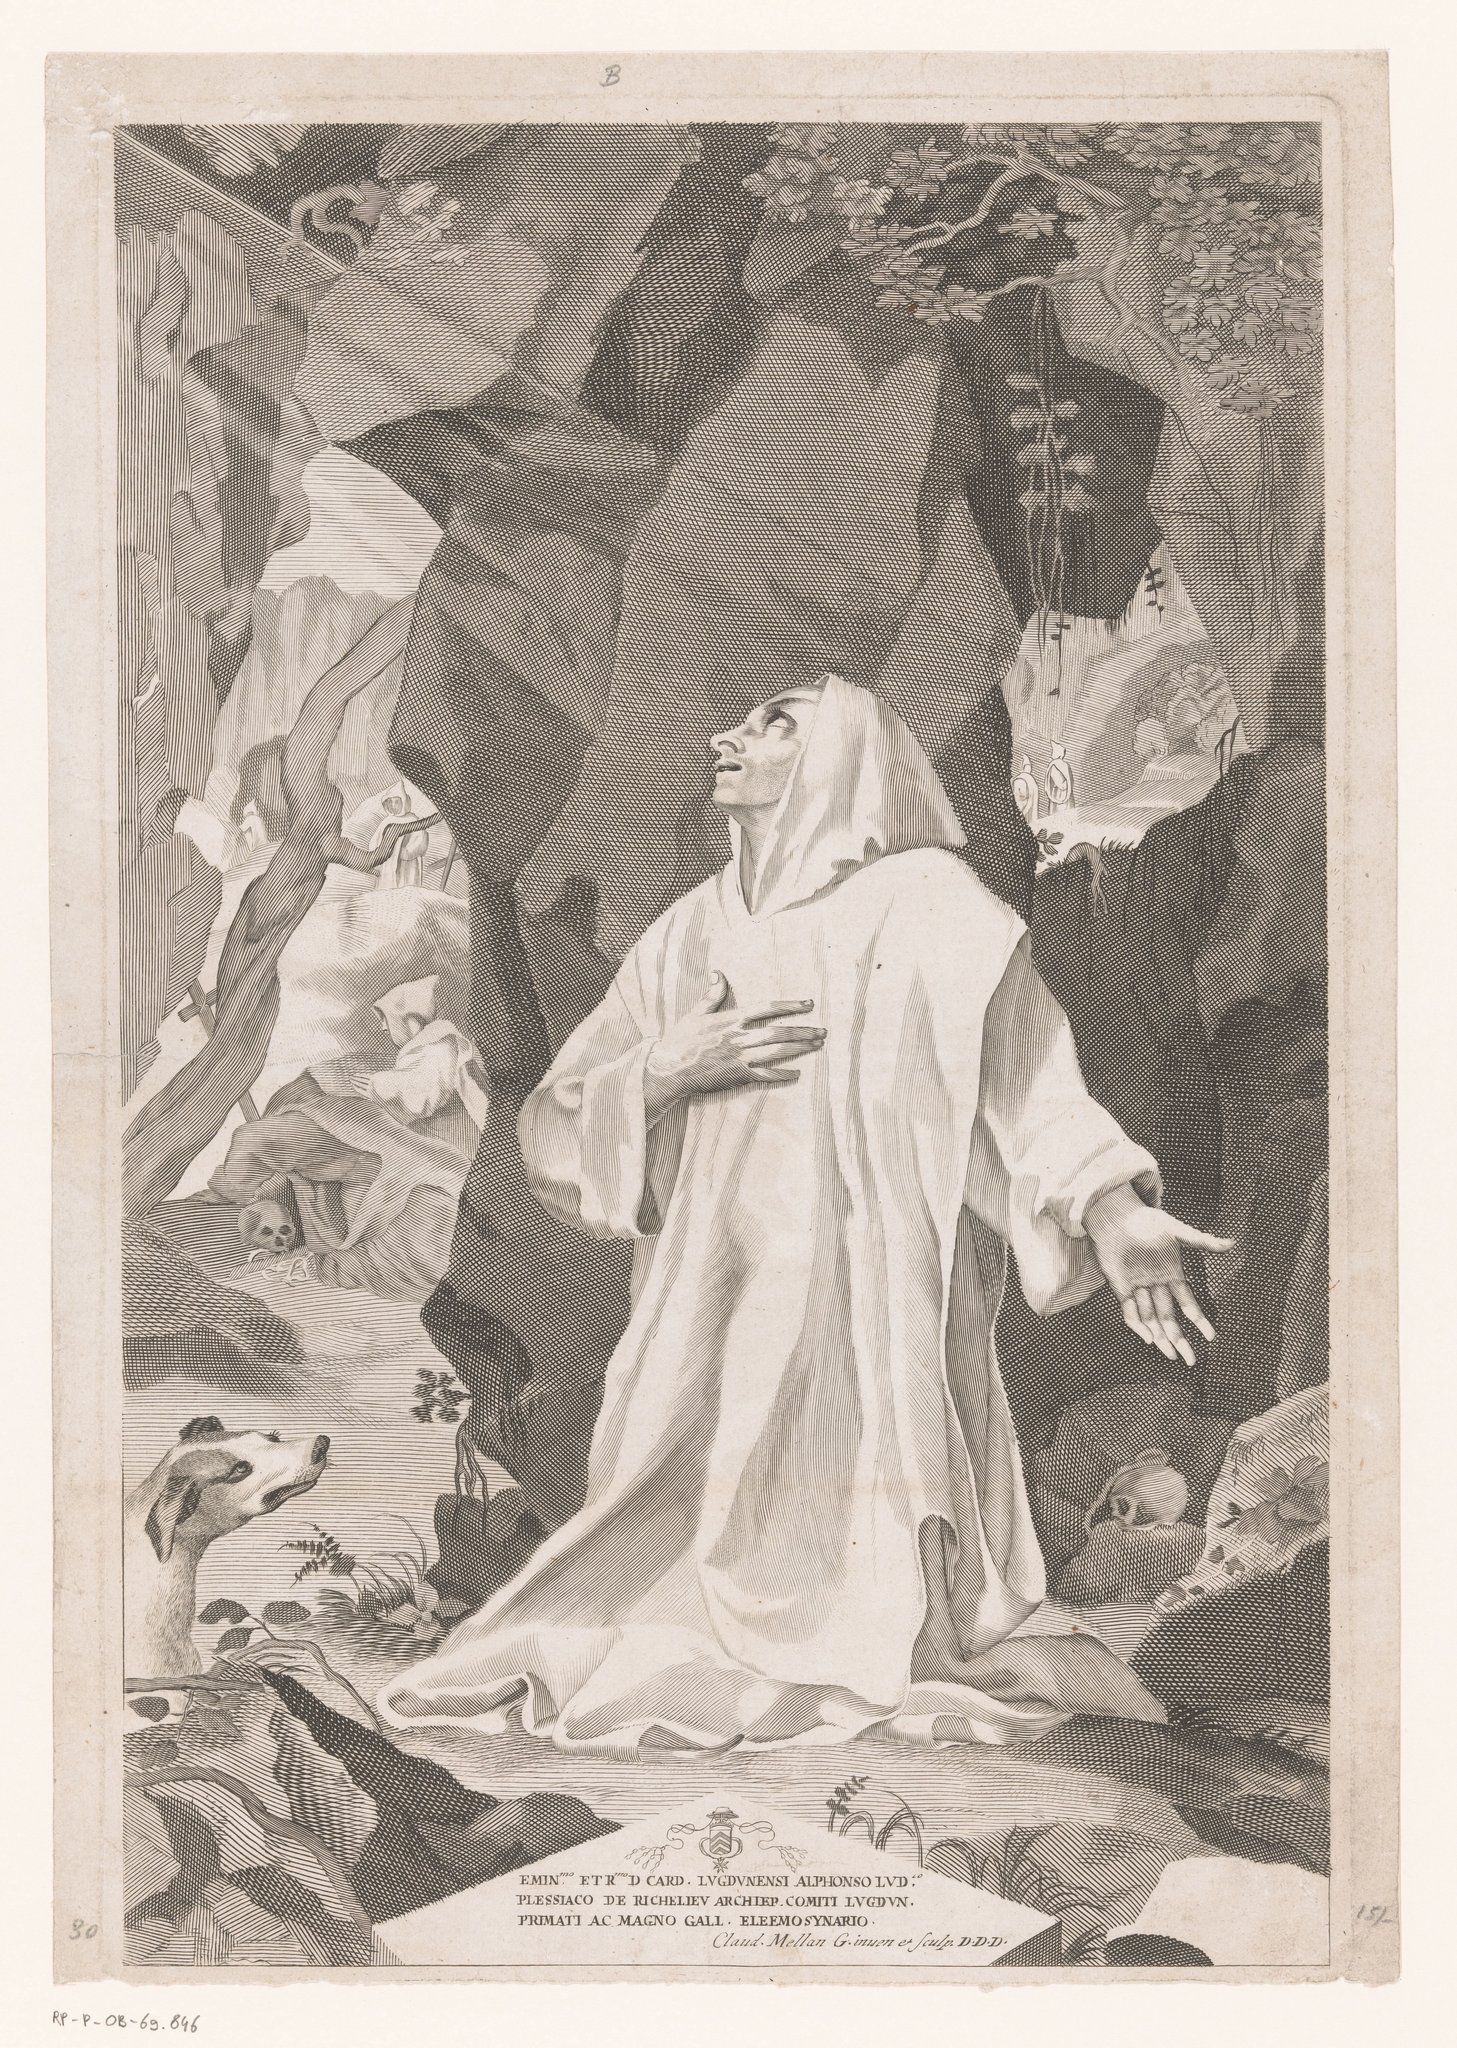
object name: print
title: H. Bruno geknield in een grot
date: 1608-1856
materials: paper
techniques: engraving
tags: the founder of the order of the carthusians, bruno; possible attributes: cross, finger at lips, lily, mitre at his feet, olive-branch, ray of light, skull, (seven) star(s), cave, grotto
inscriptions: collector's mark: Lugt 2228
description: Deze druk met opdracht, maar zonder privilege betreft volgens Anatole de Montaiglon en Mariette, p. 386, nr. 60, een moderne druk, waarbij het opschrift opnieuw lijkt te zijn gegraveerd. Zie ook IFF 17e siècle, p. 63. Waarschijnlijk betreft dit echter een kopie.